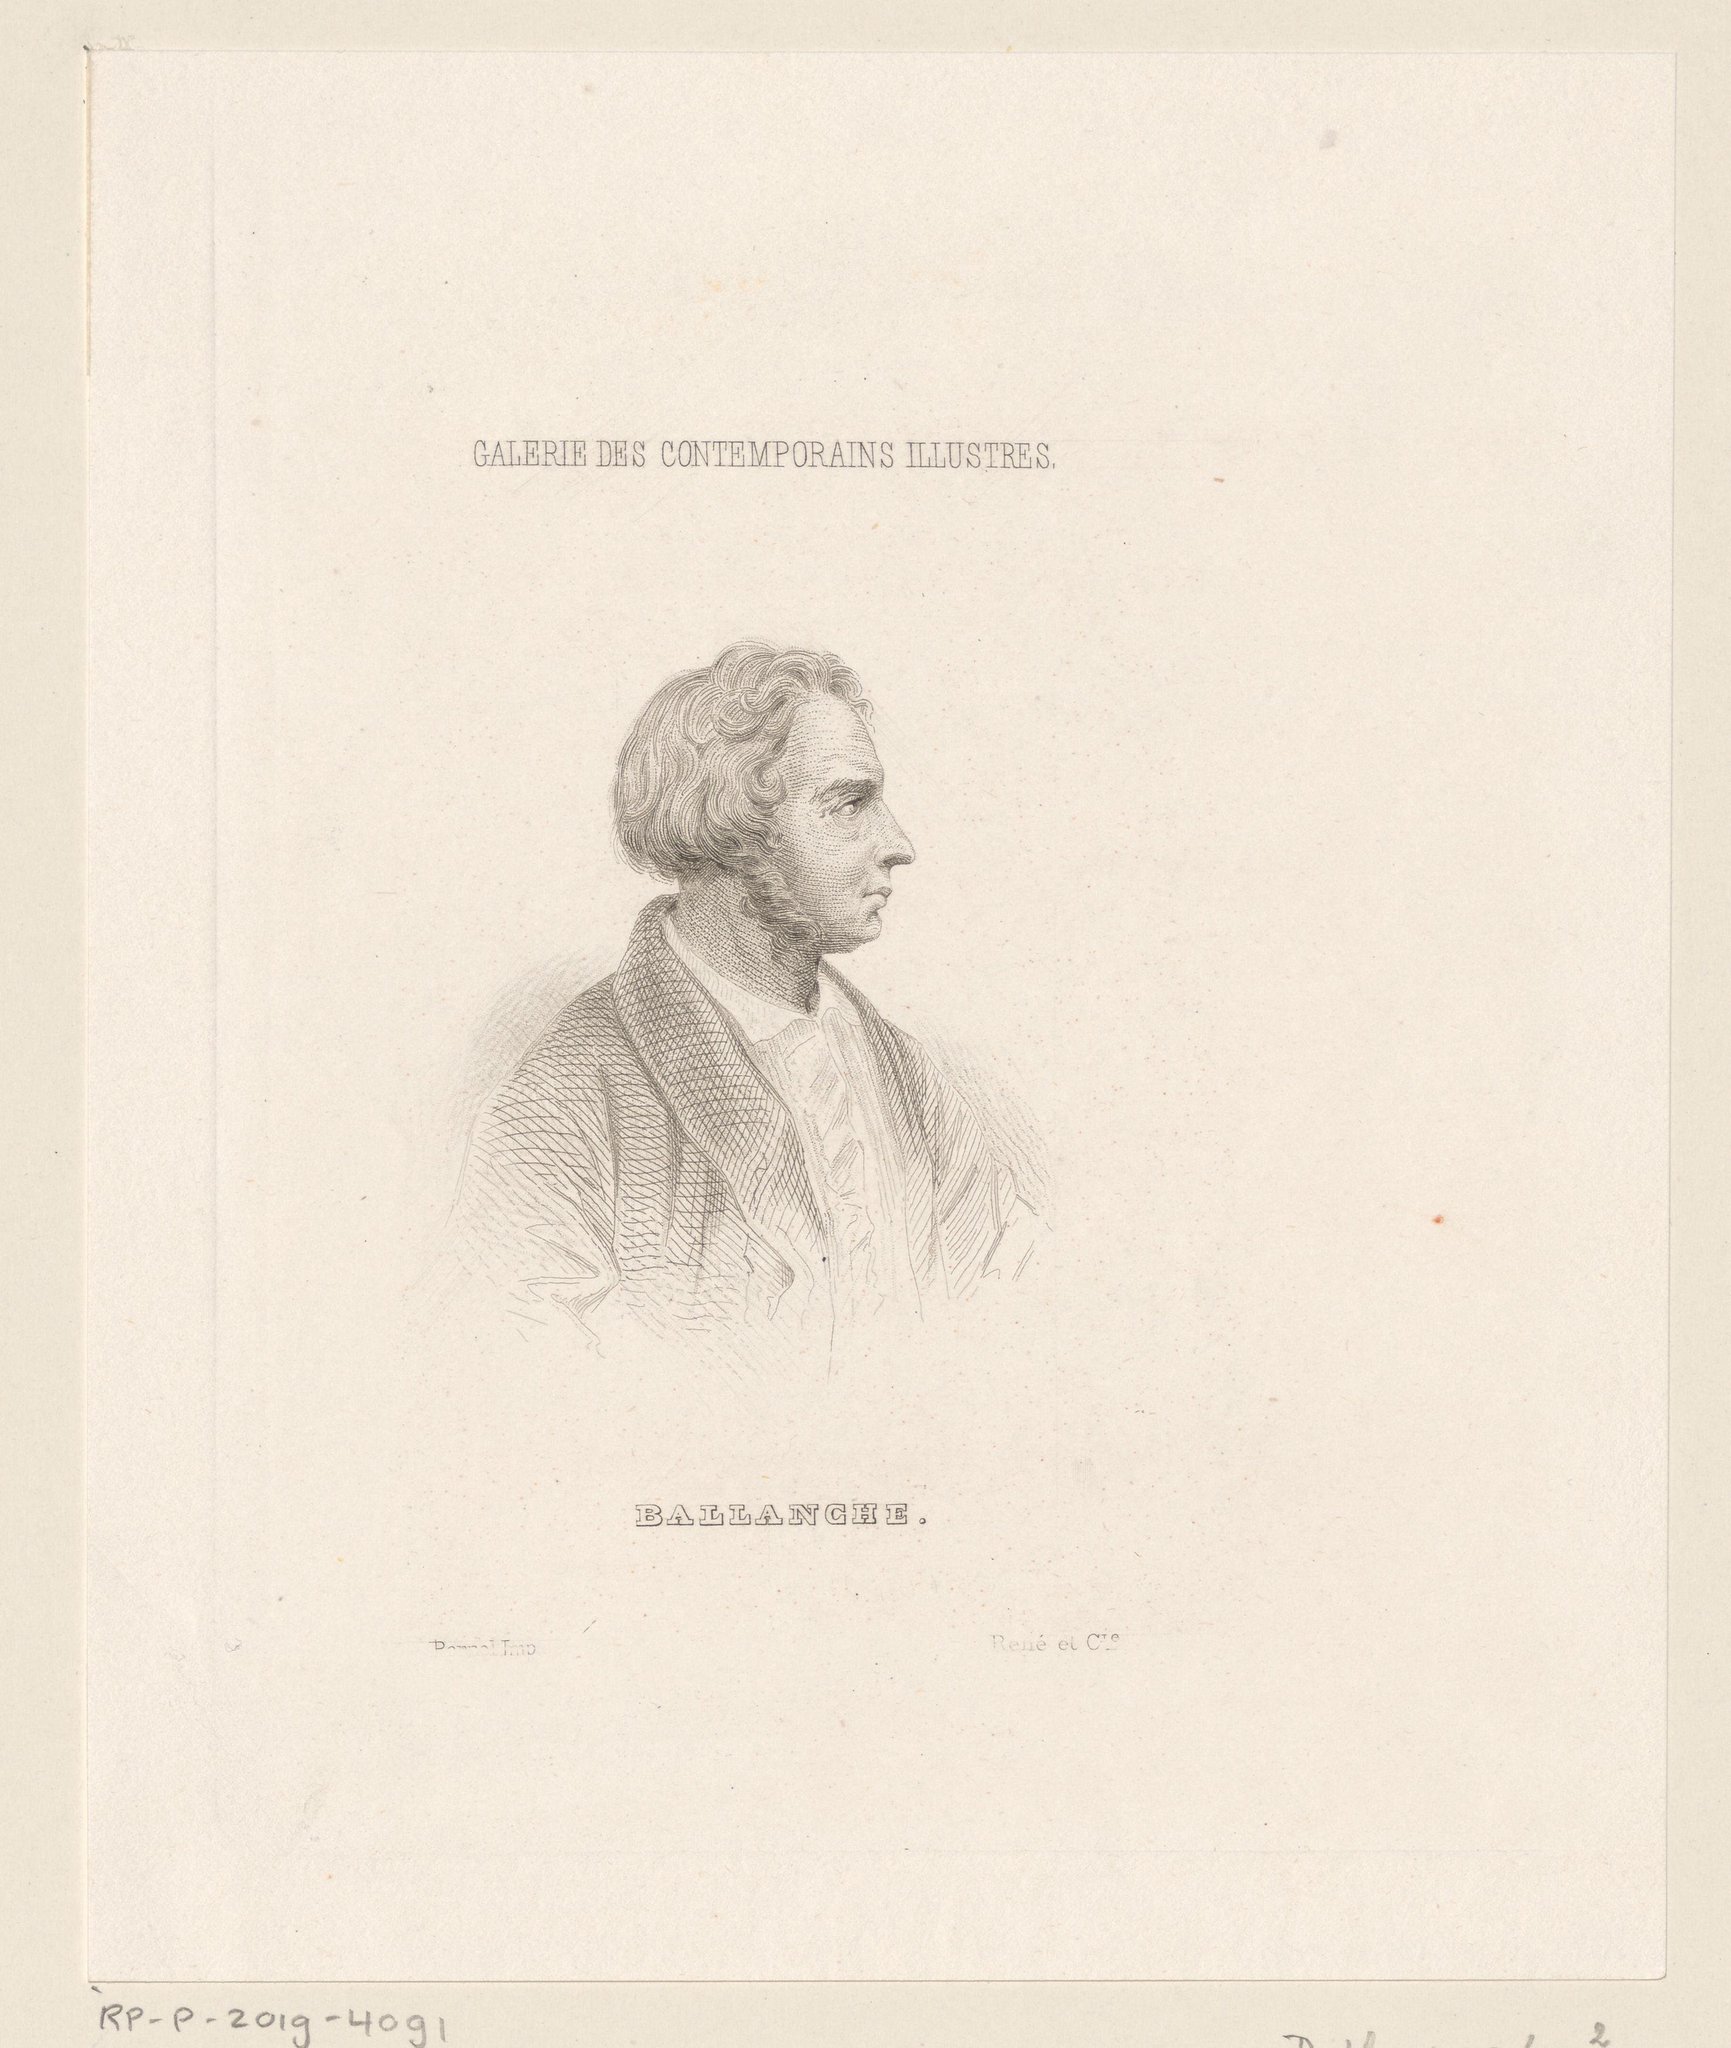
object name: print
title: Portretten van bekende tijdgenoten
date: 1841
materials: paper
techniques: etching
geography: paris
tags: lyon, paris, historical persons